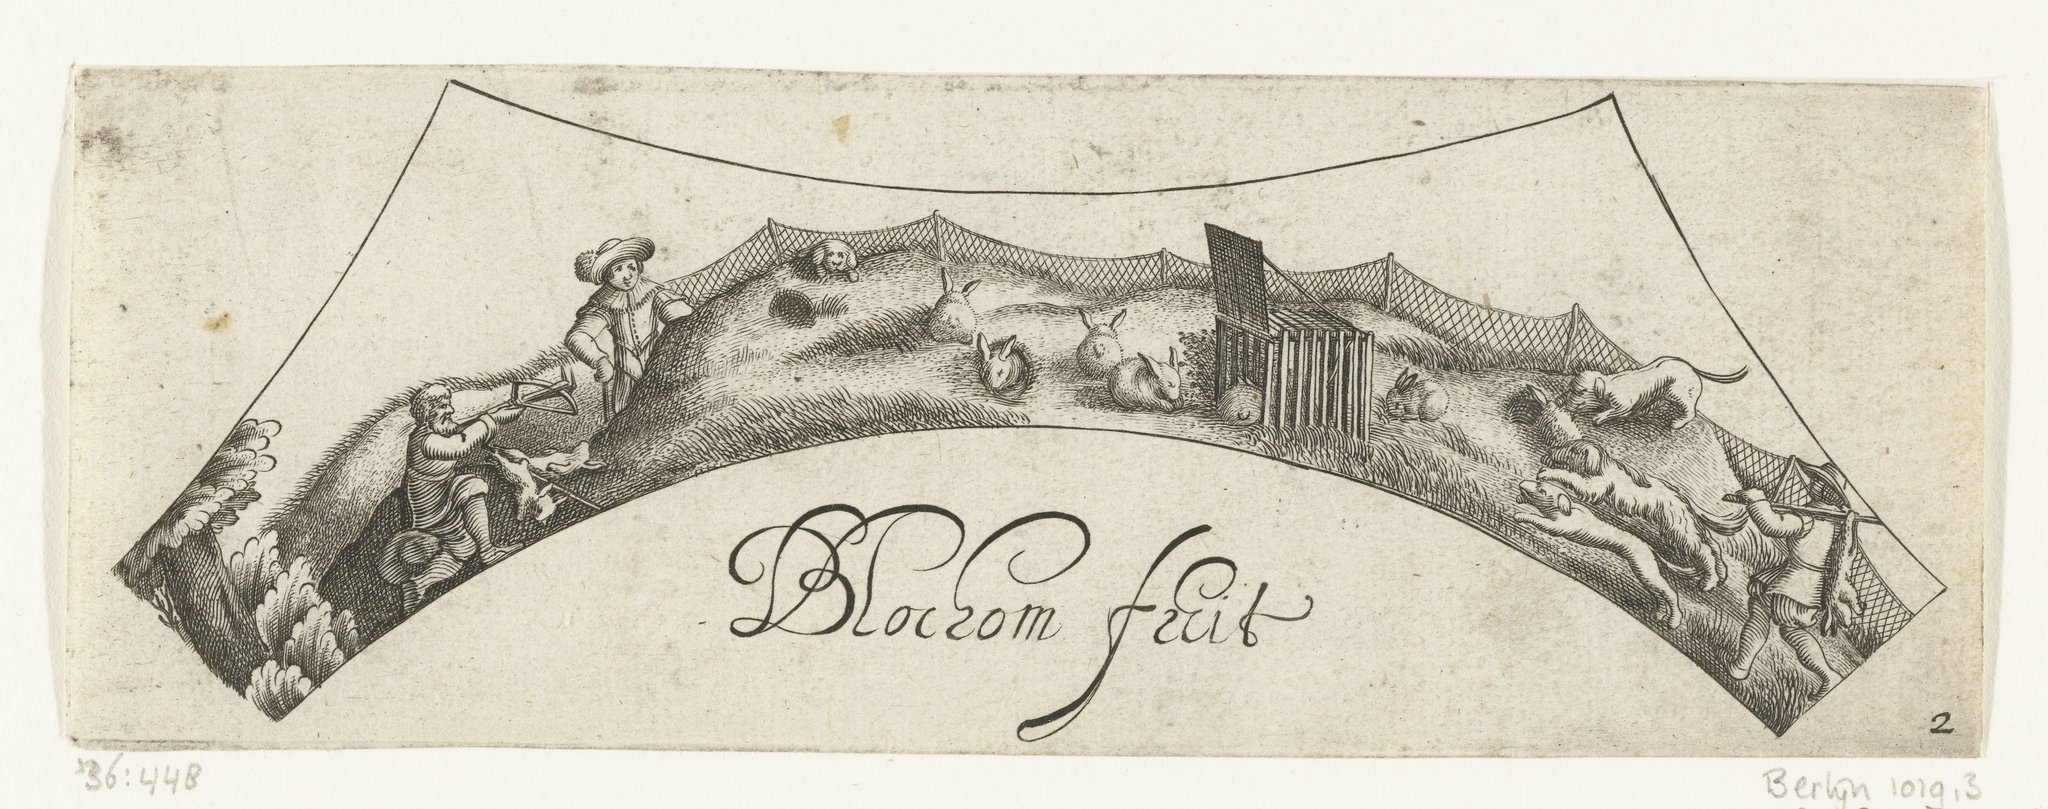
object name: print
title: Konijnenjacht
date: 1630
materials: paper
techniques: engraving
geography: amsterdam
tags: hare-hunting, rabbit-hunting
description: Drie jagers en drie honden jagen op konijnen.